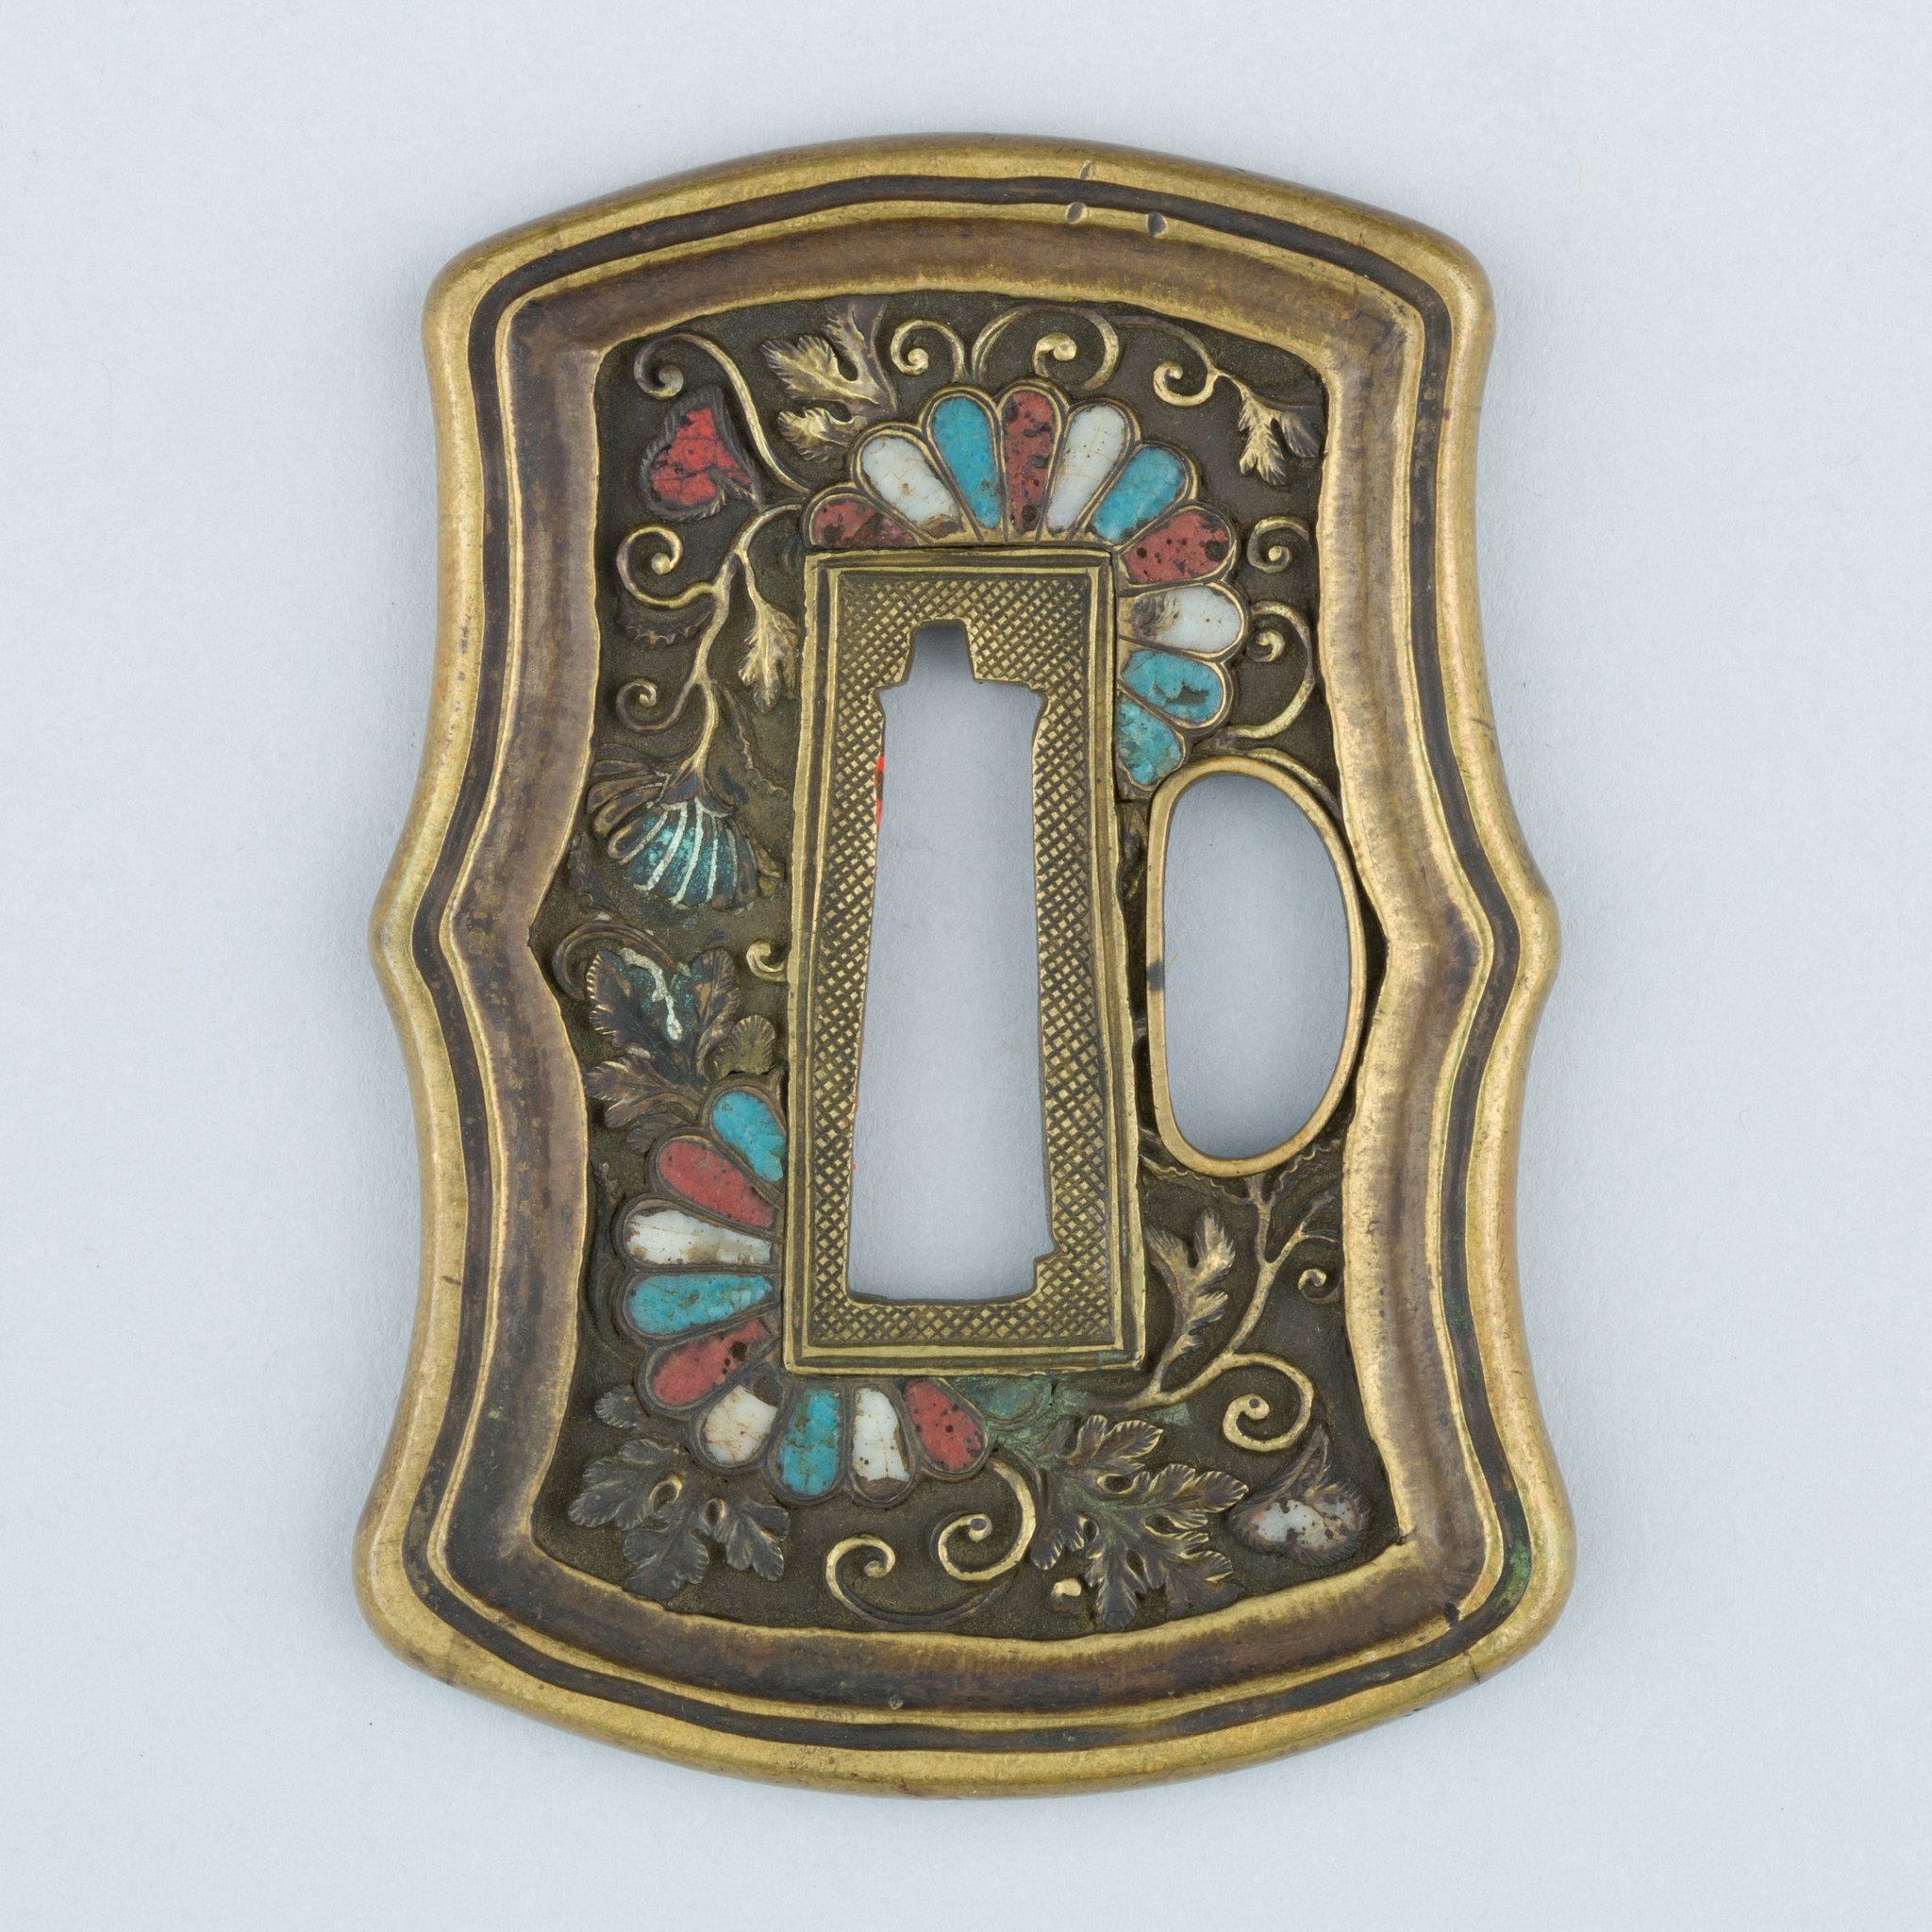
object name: sword guard tsuba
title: Sword Guard (Tsuba)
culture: japanese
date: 1615-1868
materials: copper, copper alloy, enamel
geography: japan